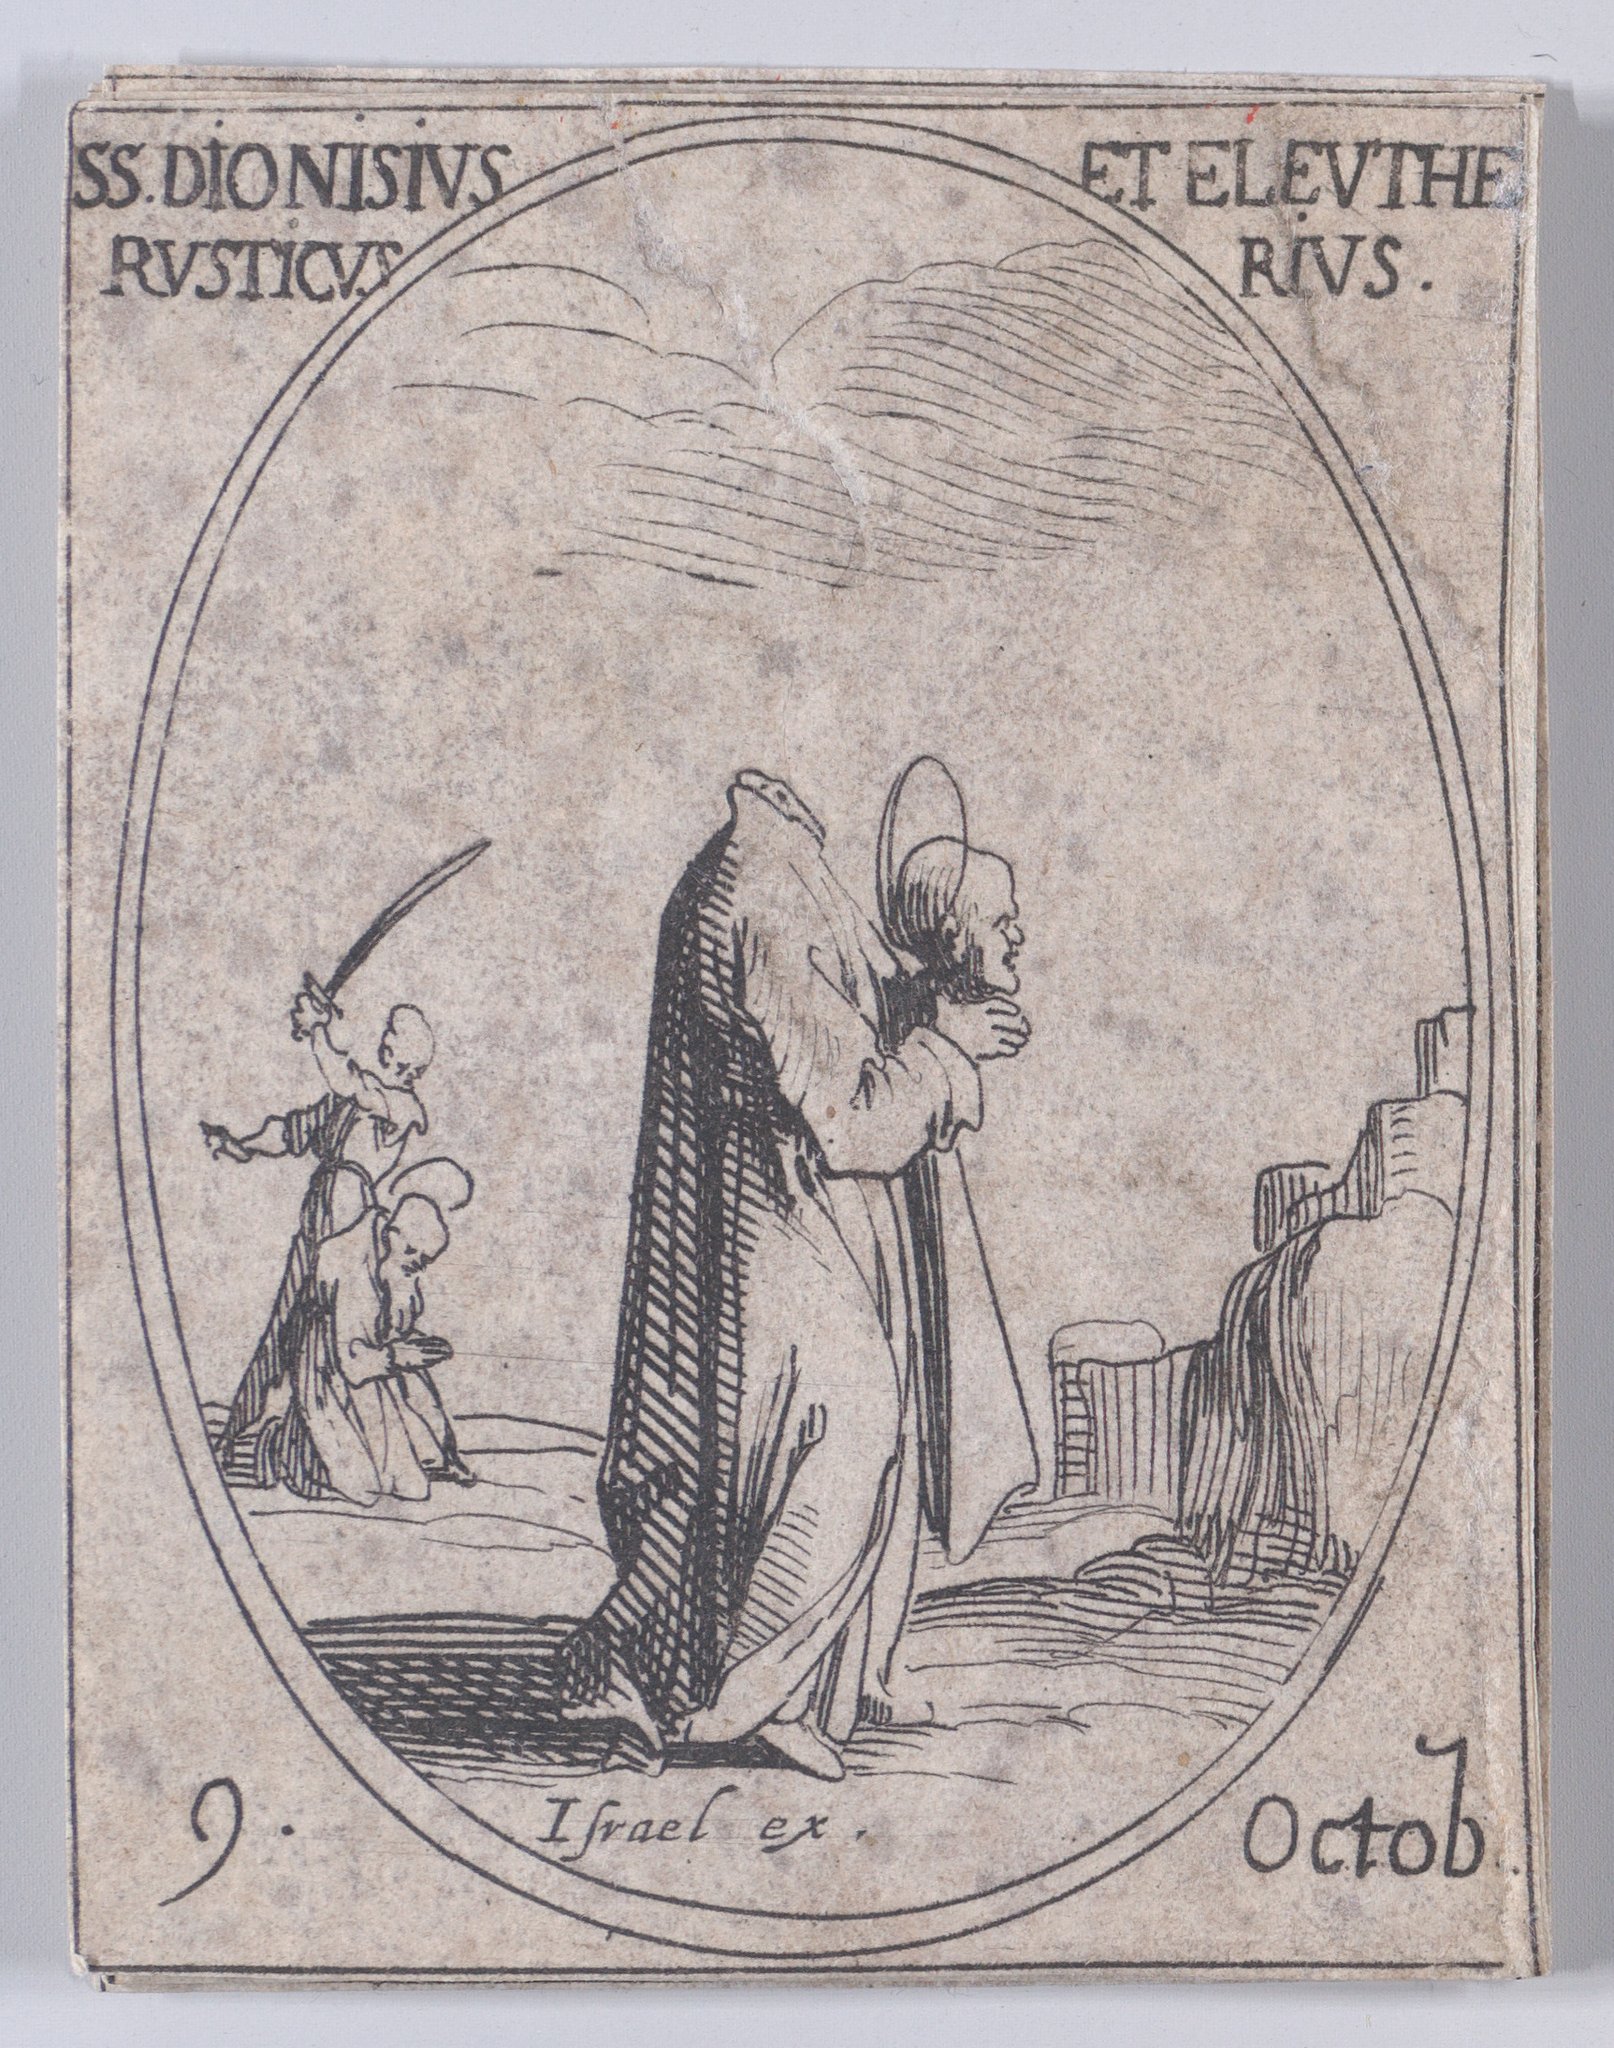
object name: print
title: S. Denis, S. Rustique et S. Eleuthère (St. Denis, St. Rusticus, and St. Eleutherius), October 9th, from "Les Images De Tous Les Saincts et Saintes de L'Année" (Images of All of the Saints and Religious Events of the Year)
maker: jacques callot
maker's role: artist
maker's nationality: french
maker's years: 1592-1635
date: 1636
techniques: etching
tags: men,saints